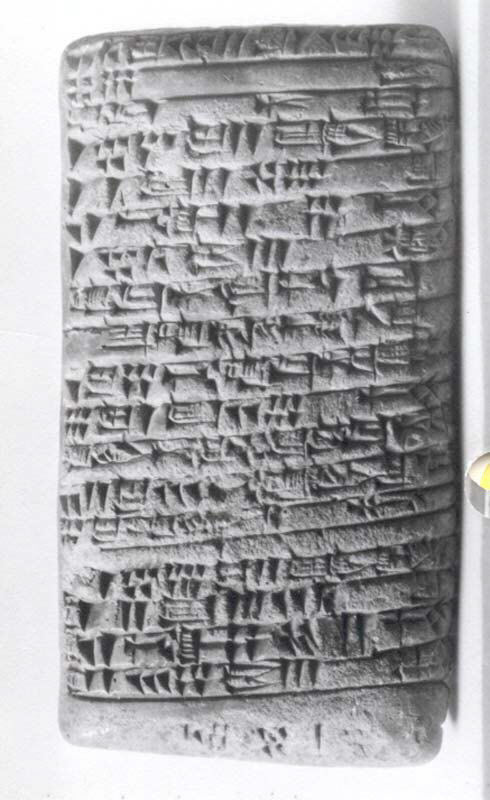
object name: cuneiform tablet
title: Cuneiform tablet: balanced account of Kaamu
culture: neo-sumerian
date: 2038 BCE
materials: clay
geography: mesopotamia